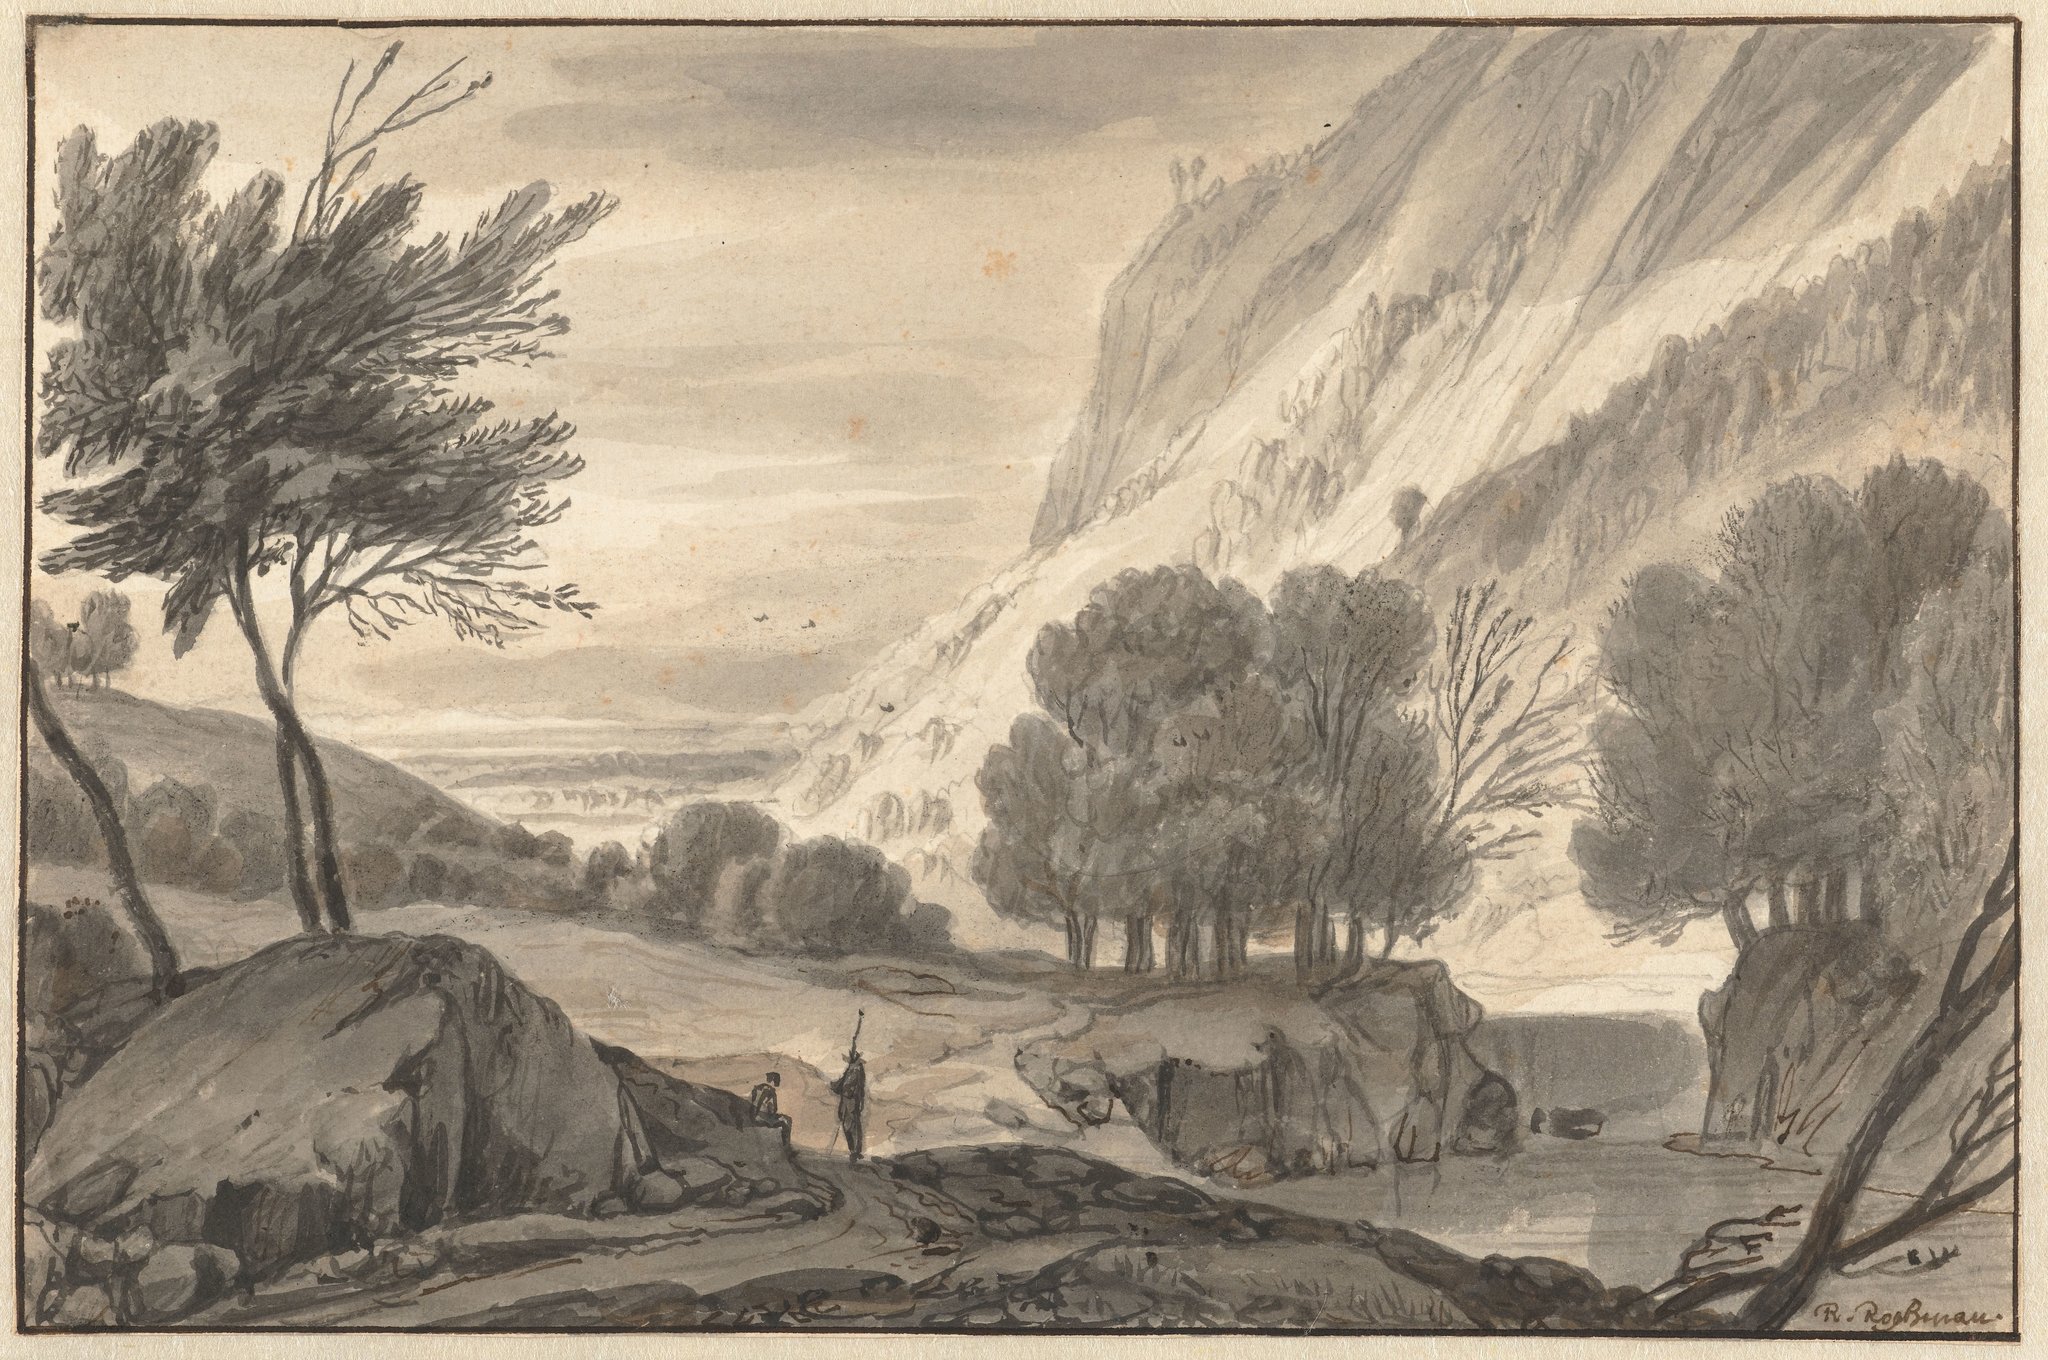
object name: drawing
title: Mountainous Landscape with Two Travellers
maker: roelant roghman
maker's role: draughtsman, painter, print maker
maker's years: 1627-1692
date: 1660-1670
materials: chalk, ink, paper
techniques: brush, pen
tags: mountains